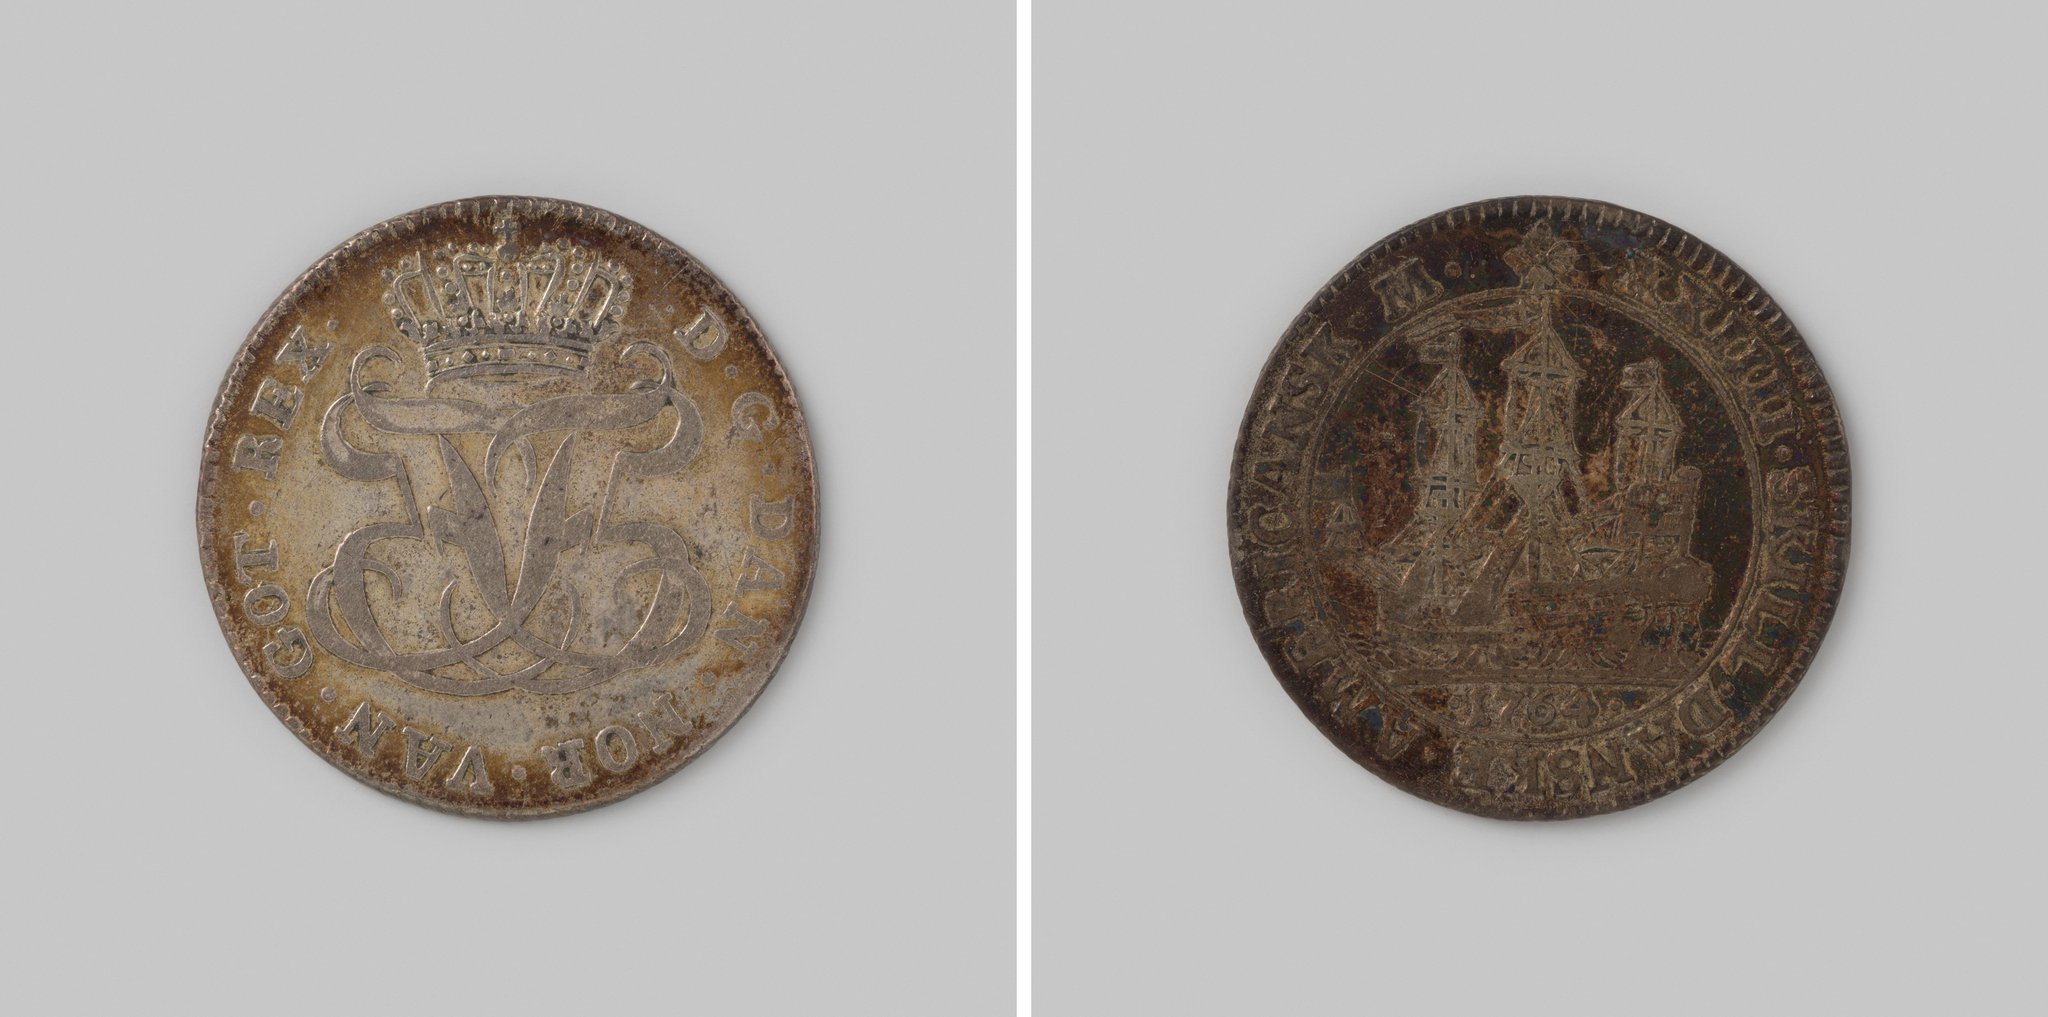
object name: coin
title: 24 skilling uit Deens West-Indië van koning Frederik V,1764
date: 1764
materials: silver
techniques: striking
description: Zilveren munt. Voorzijde: gekroond monogram van de koning. Keerzijde: driemaster varend naar links. In afsnede jaartal. Waarde-aanduiding in omschrift. Kabelrand.